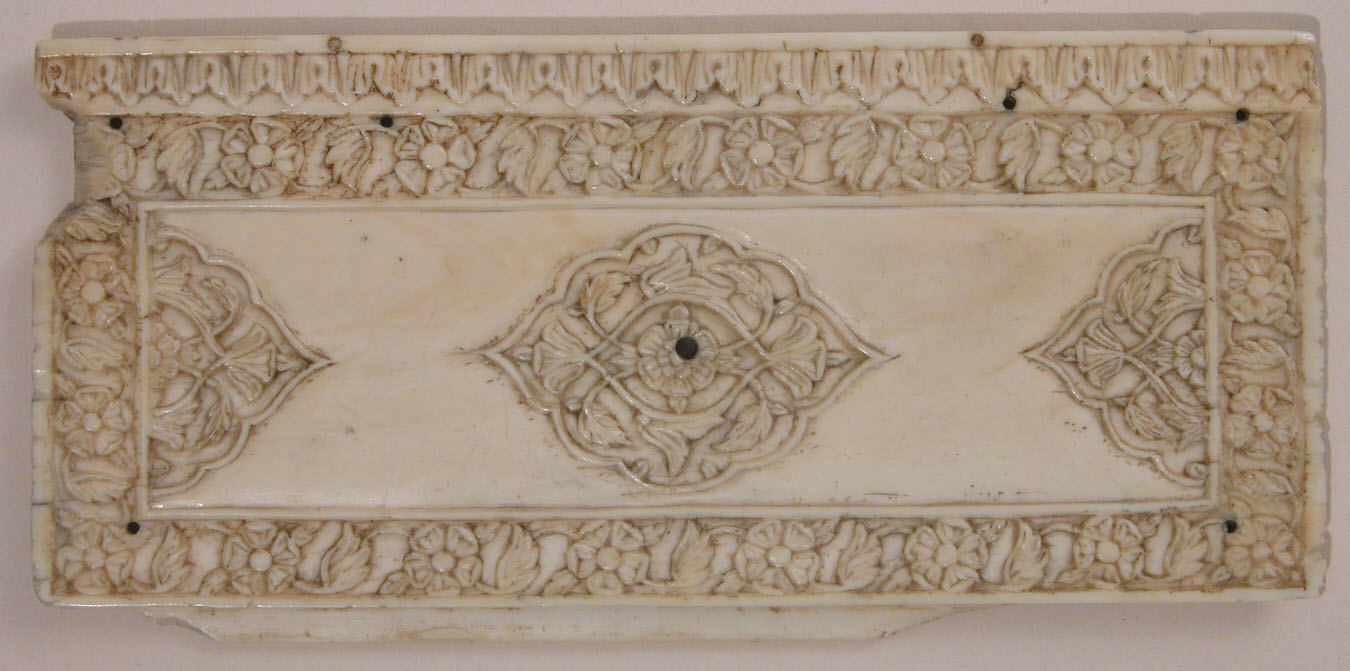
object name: fragment of a box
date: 1601-1700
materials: ivory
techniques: carving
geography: india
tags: flowers,leaves